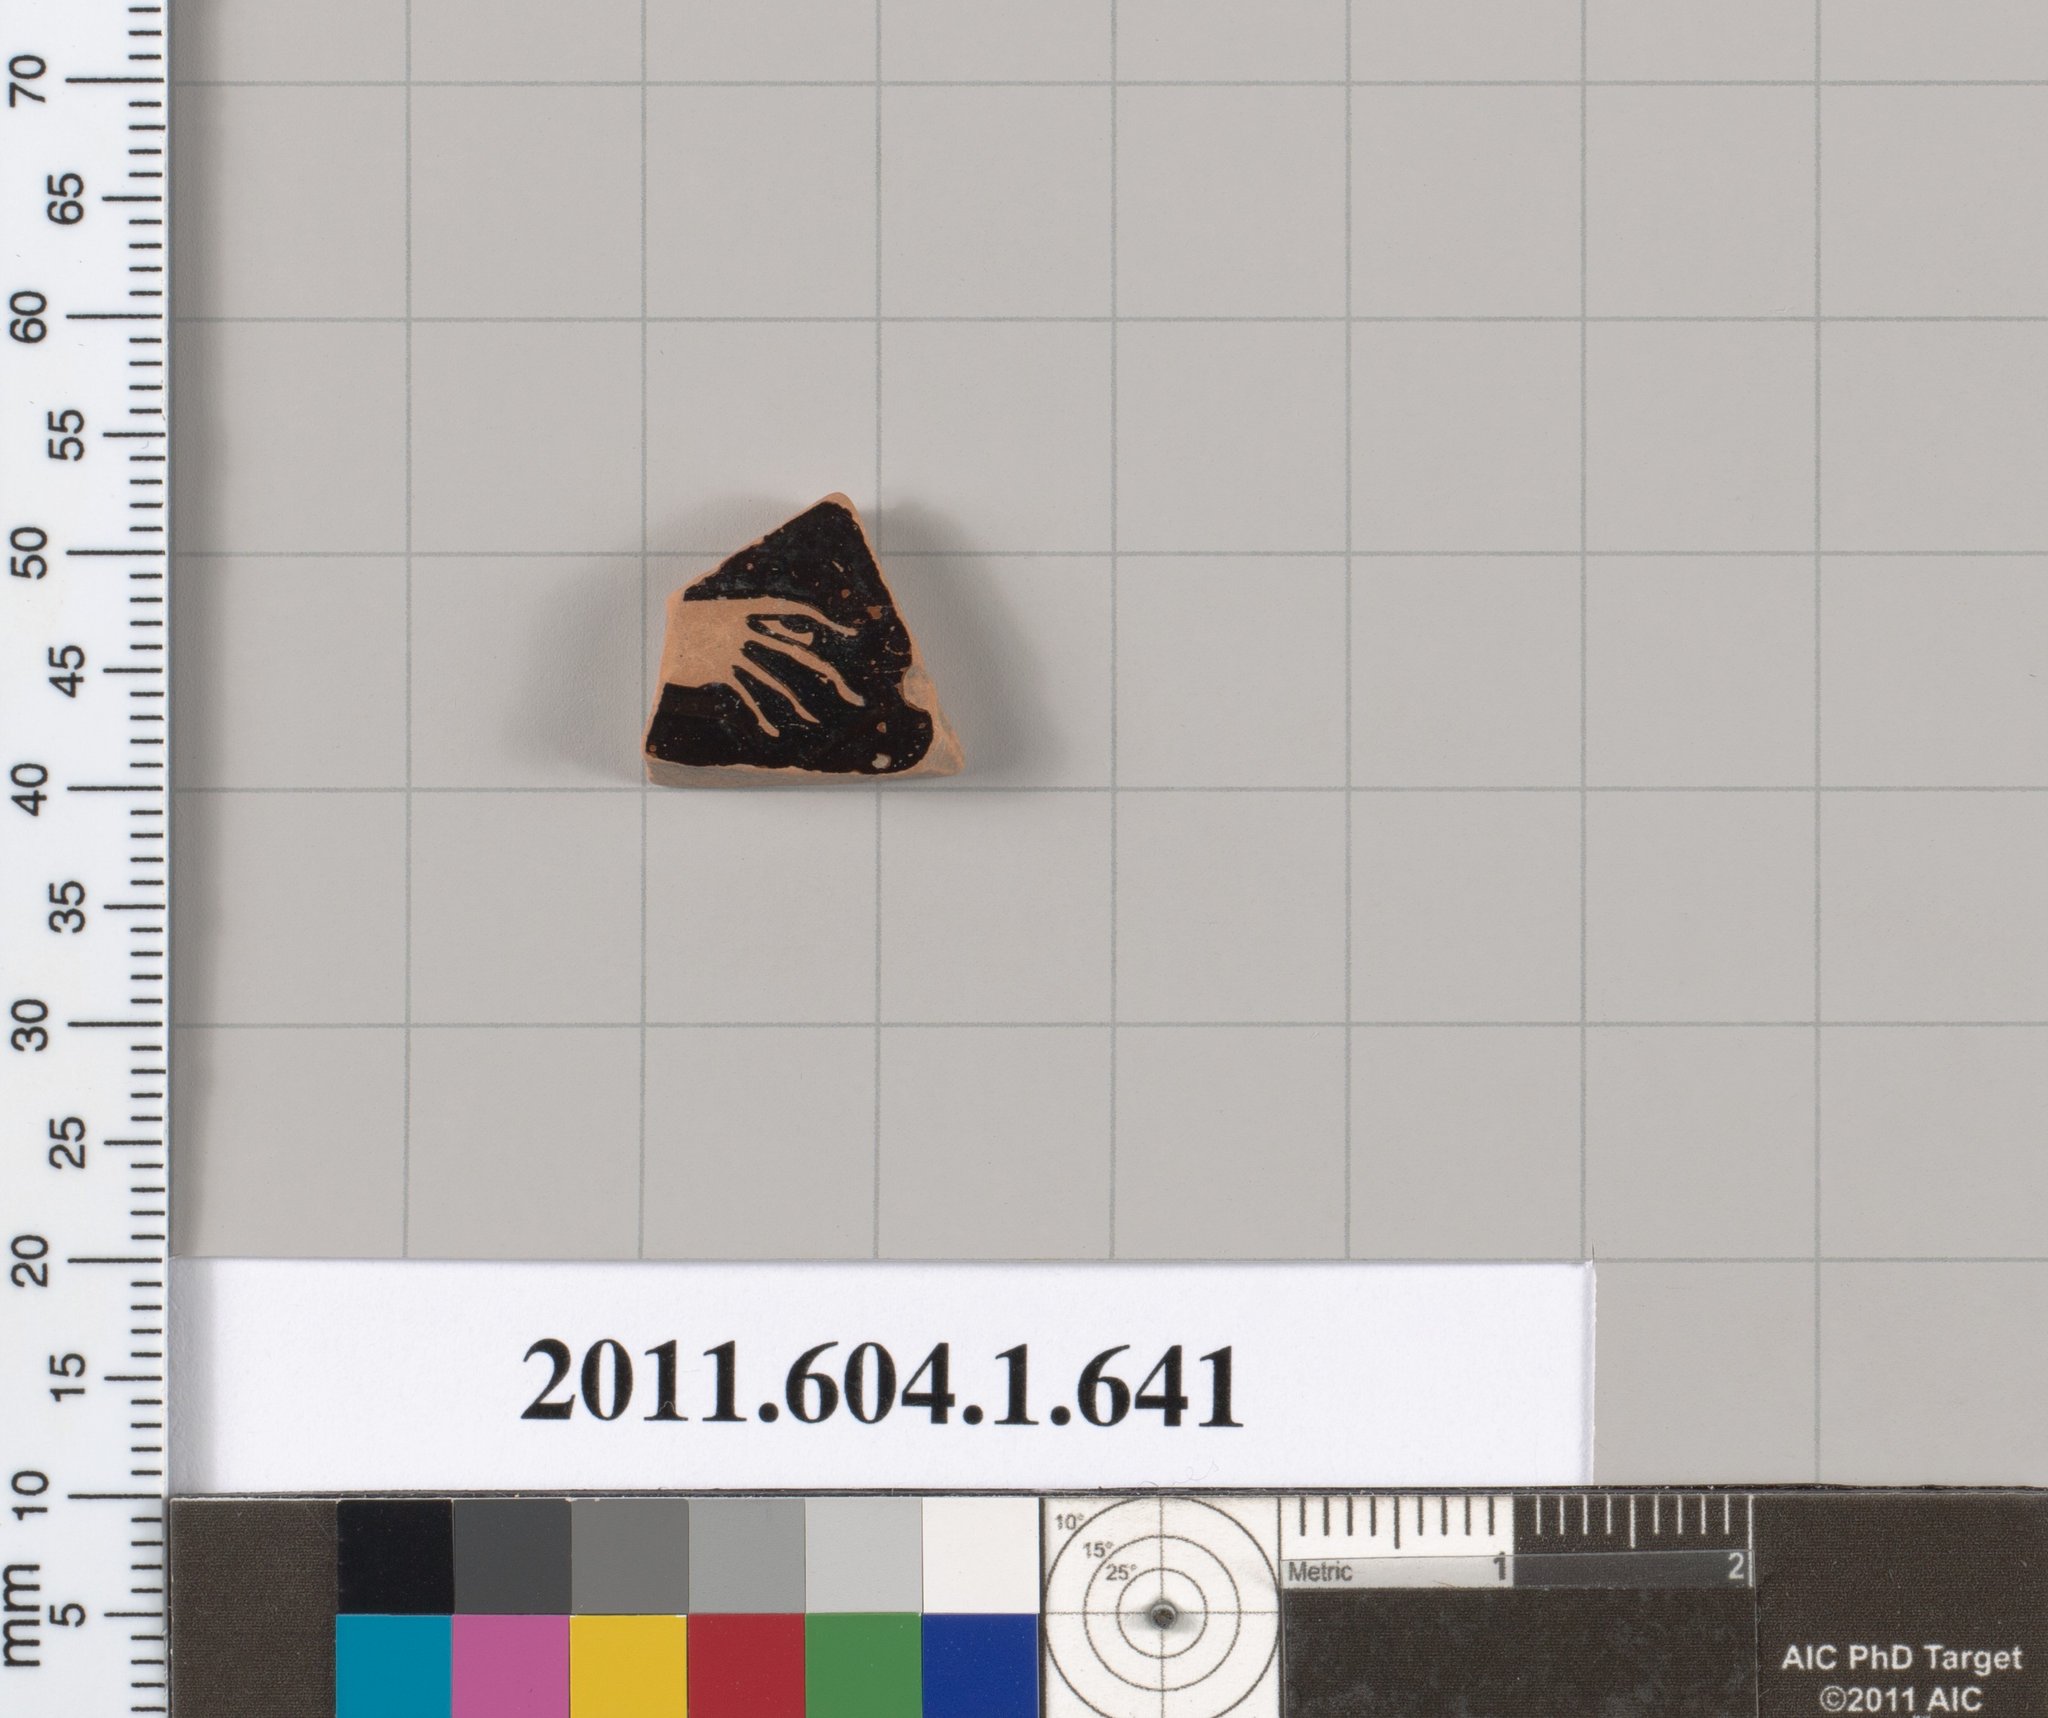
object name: kylix fragment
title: Terracotta fragment of a kylix (drinking cup)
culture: greek, attic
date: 475-451 BCE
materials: terracotta